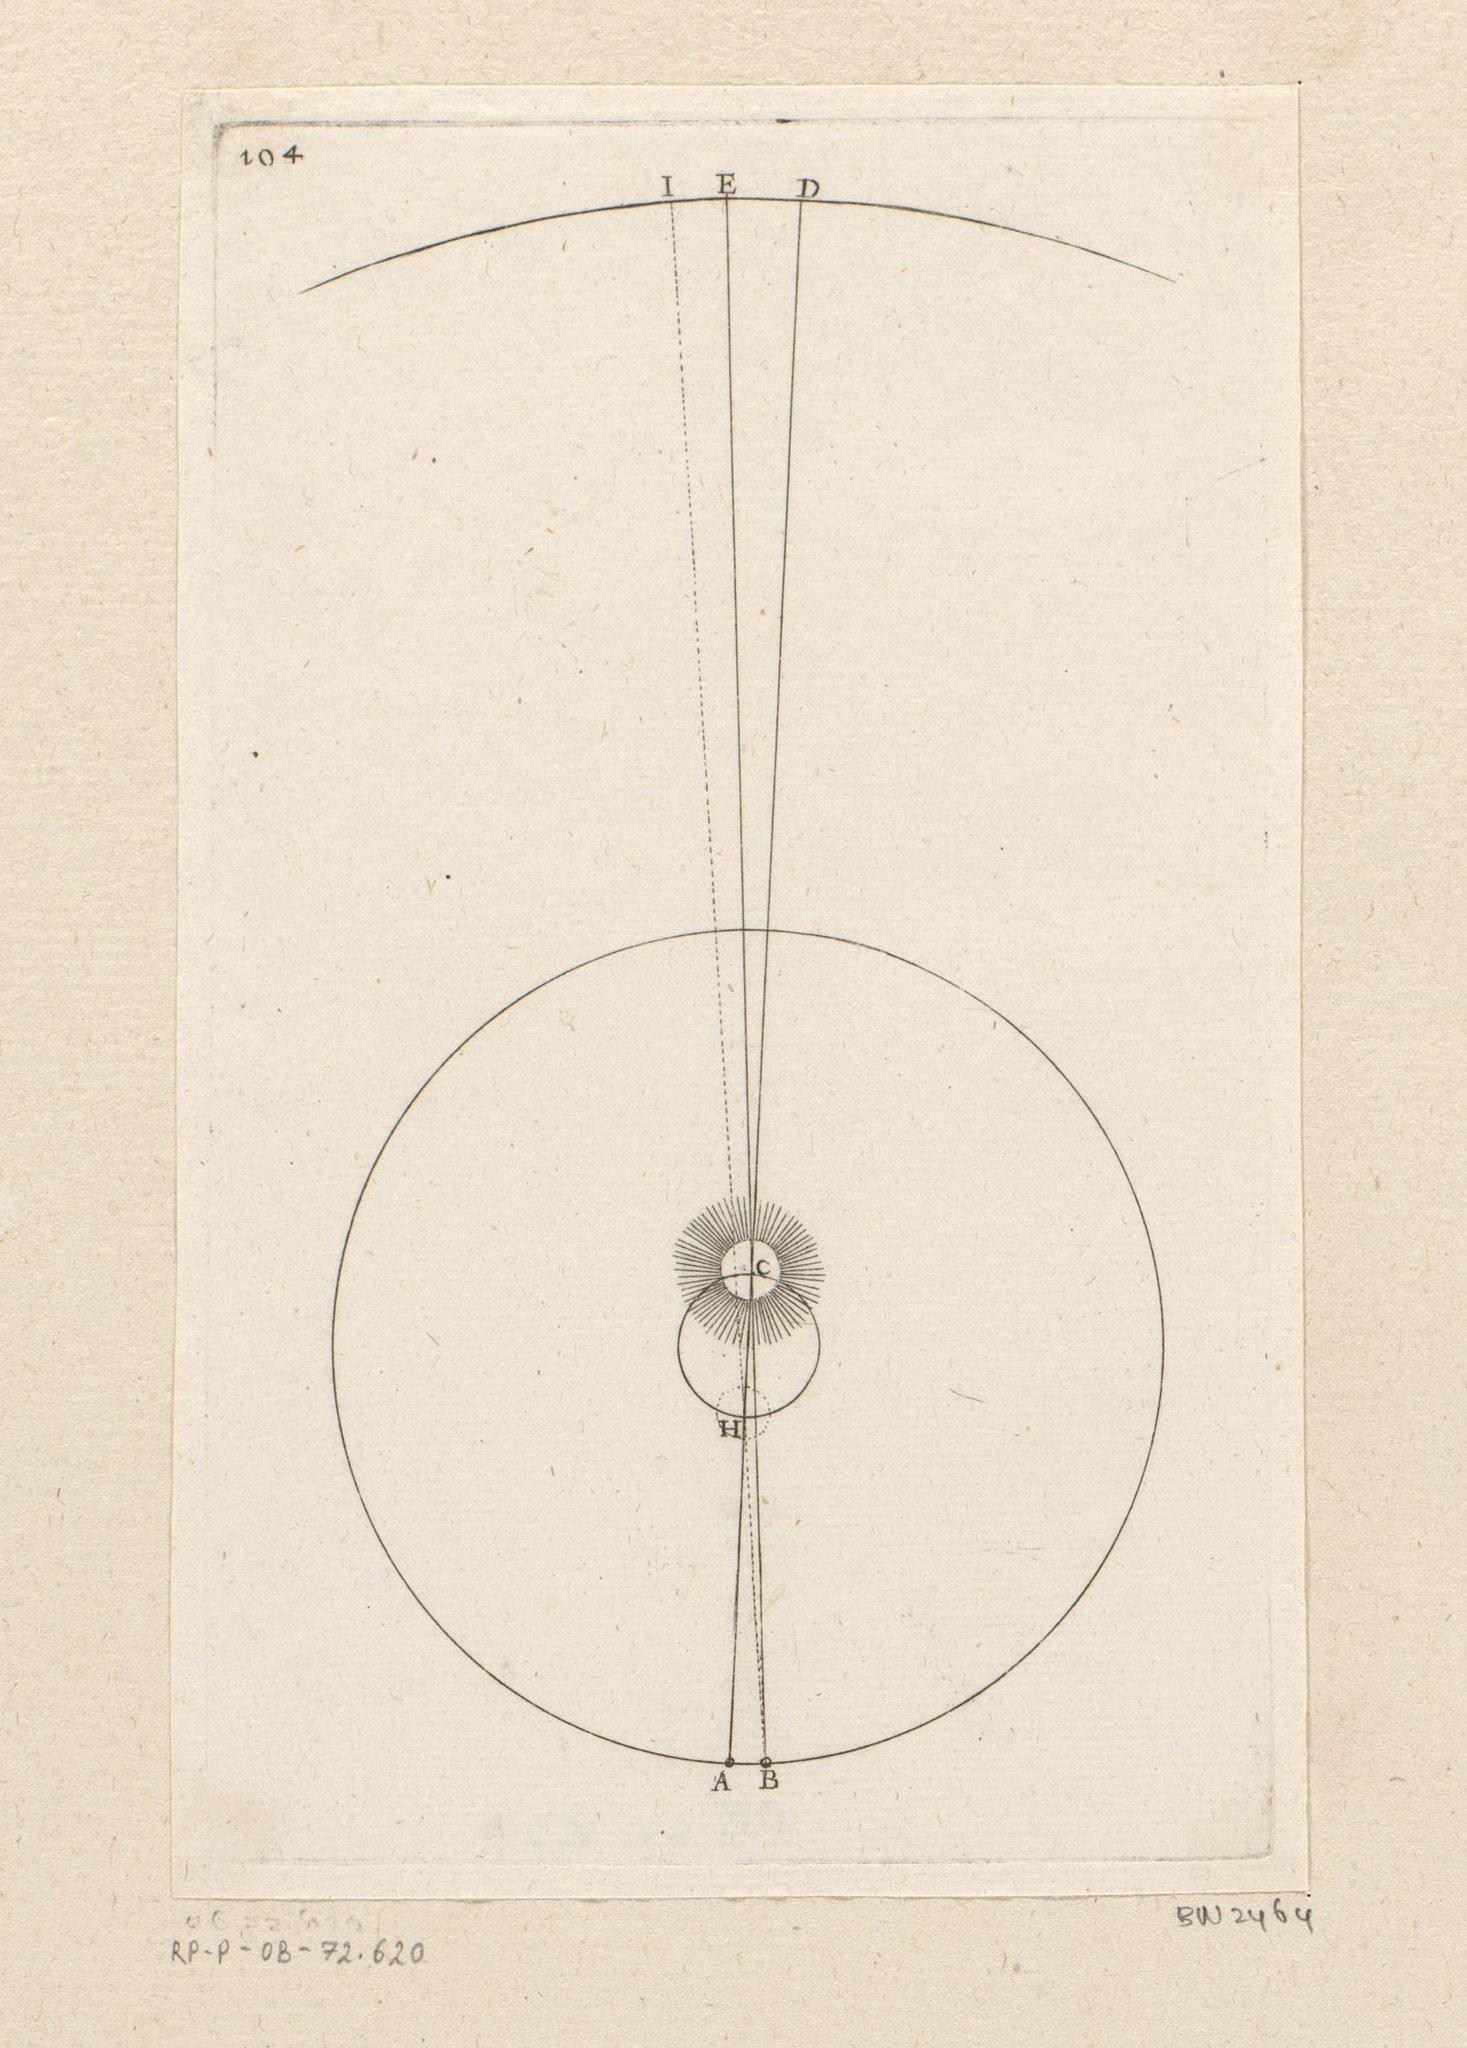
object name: book illustration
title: Banen van de Aarde en de Zon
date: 1706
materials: paper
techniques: etching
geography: france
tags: earth, world as celestial body, day of 24 hours, natural day, sun as celestial body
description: Prent uit: Leclerc, Sébastien. Nouveau systeme du monde conforme à l'Ecriture sainte. Où les phénomènes sont expliquez sans excentricité de mouvement (...). Paris: Pierre Giffart, 1706.